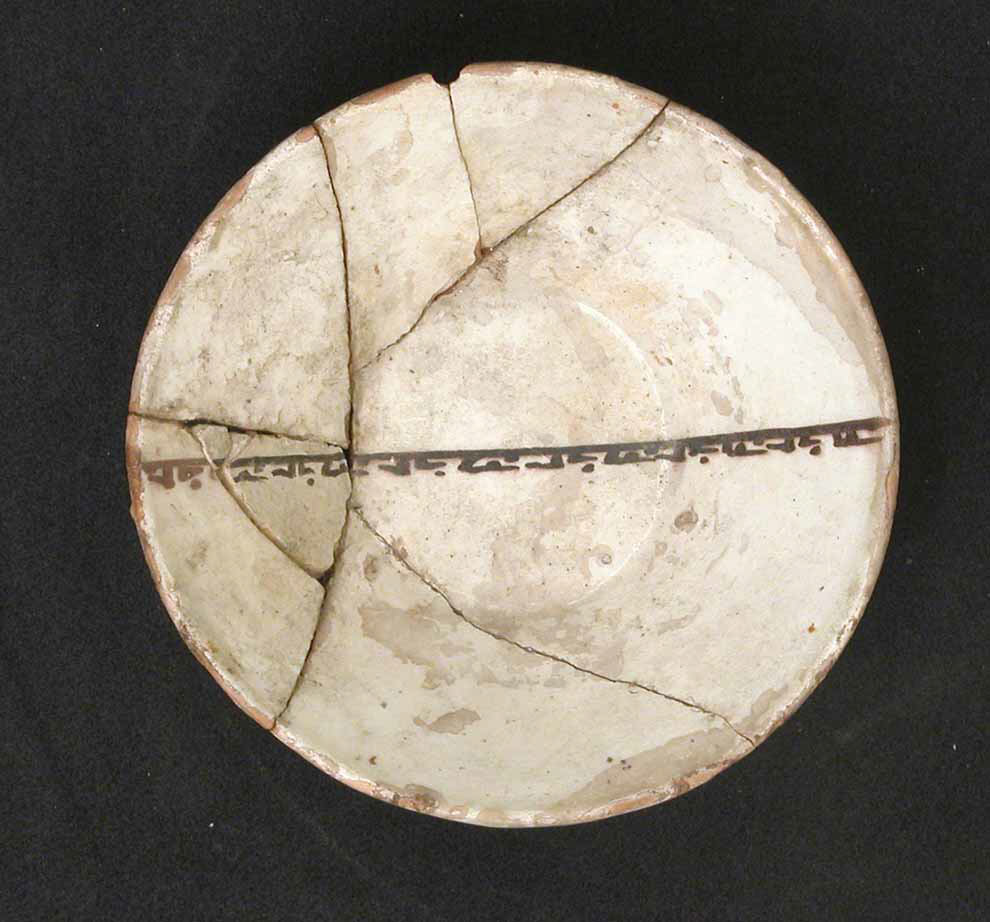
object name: bowl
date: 901-1000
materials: earthenware, glaze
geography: uzbekistan